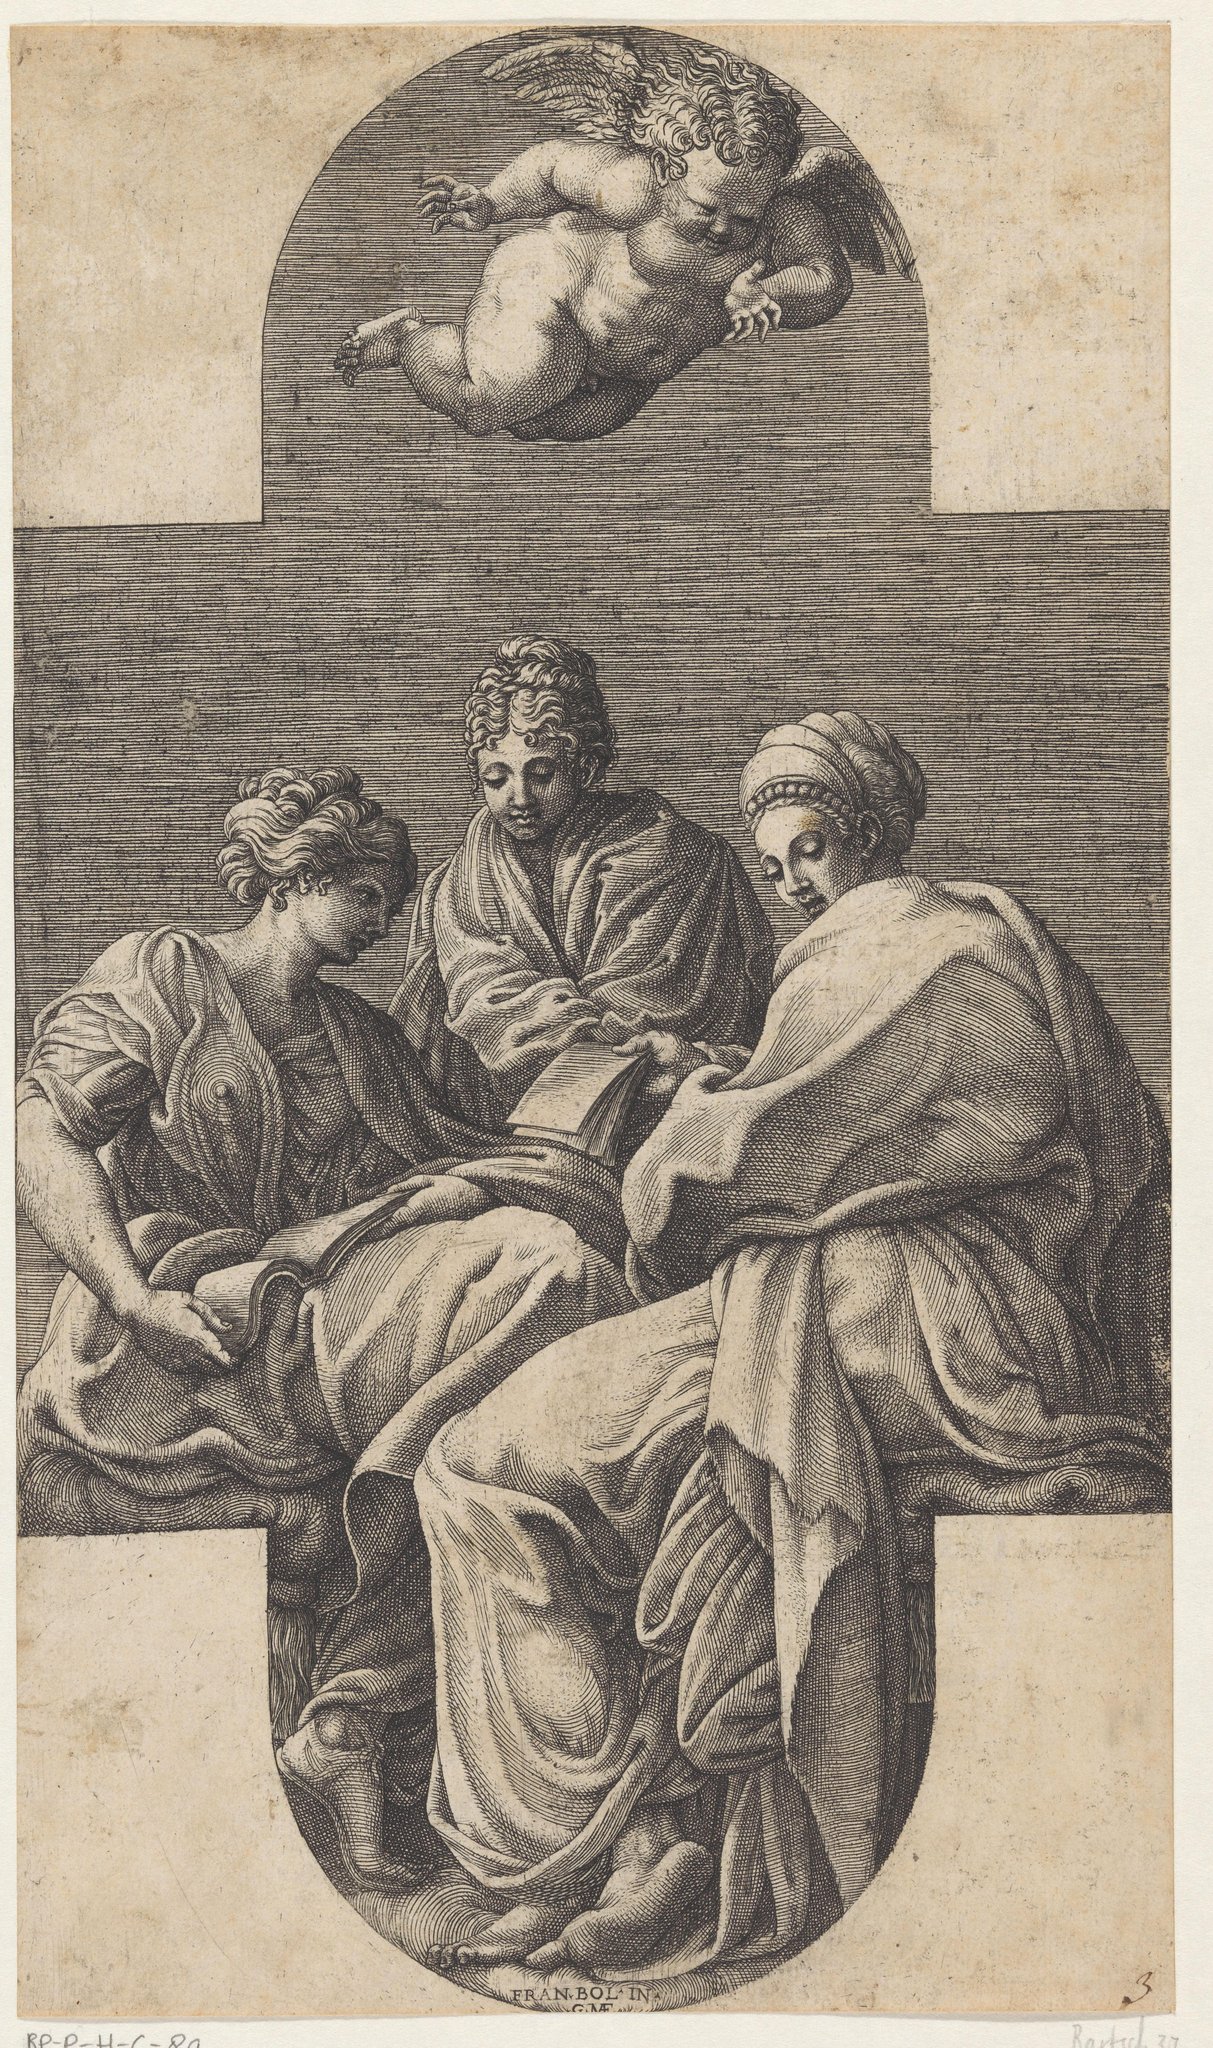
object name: print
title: Drie Muzen en een gebarende putto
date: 1541-1582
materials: paper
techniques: engraving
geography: italy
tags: the muses acting together (as group), cupids: 'amores', 'amoretti', 'putti'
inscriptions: number: ‘25’, number: ‘3’, collector's mark: ‘Hinloopen’, collector's mark: Lugt 11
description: Prent uit een reeks van vier prenten naar plafondschilderingen in de Galerie d'Ulysse te Fontainebleau, door Francesco Primaticcio.